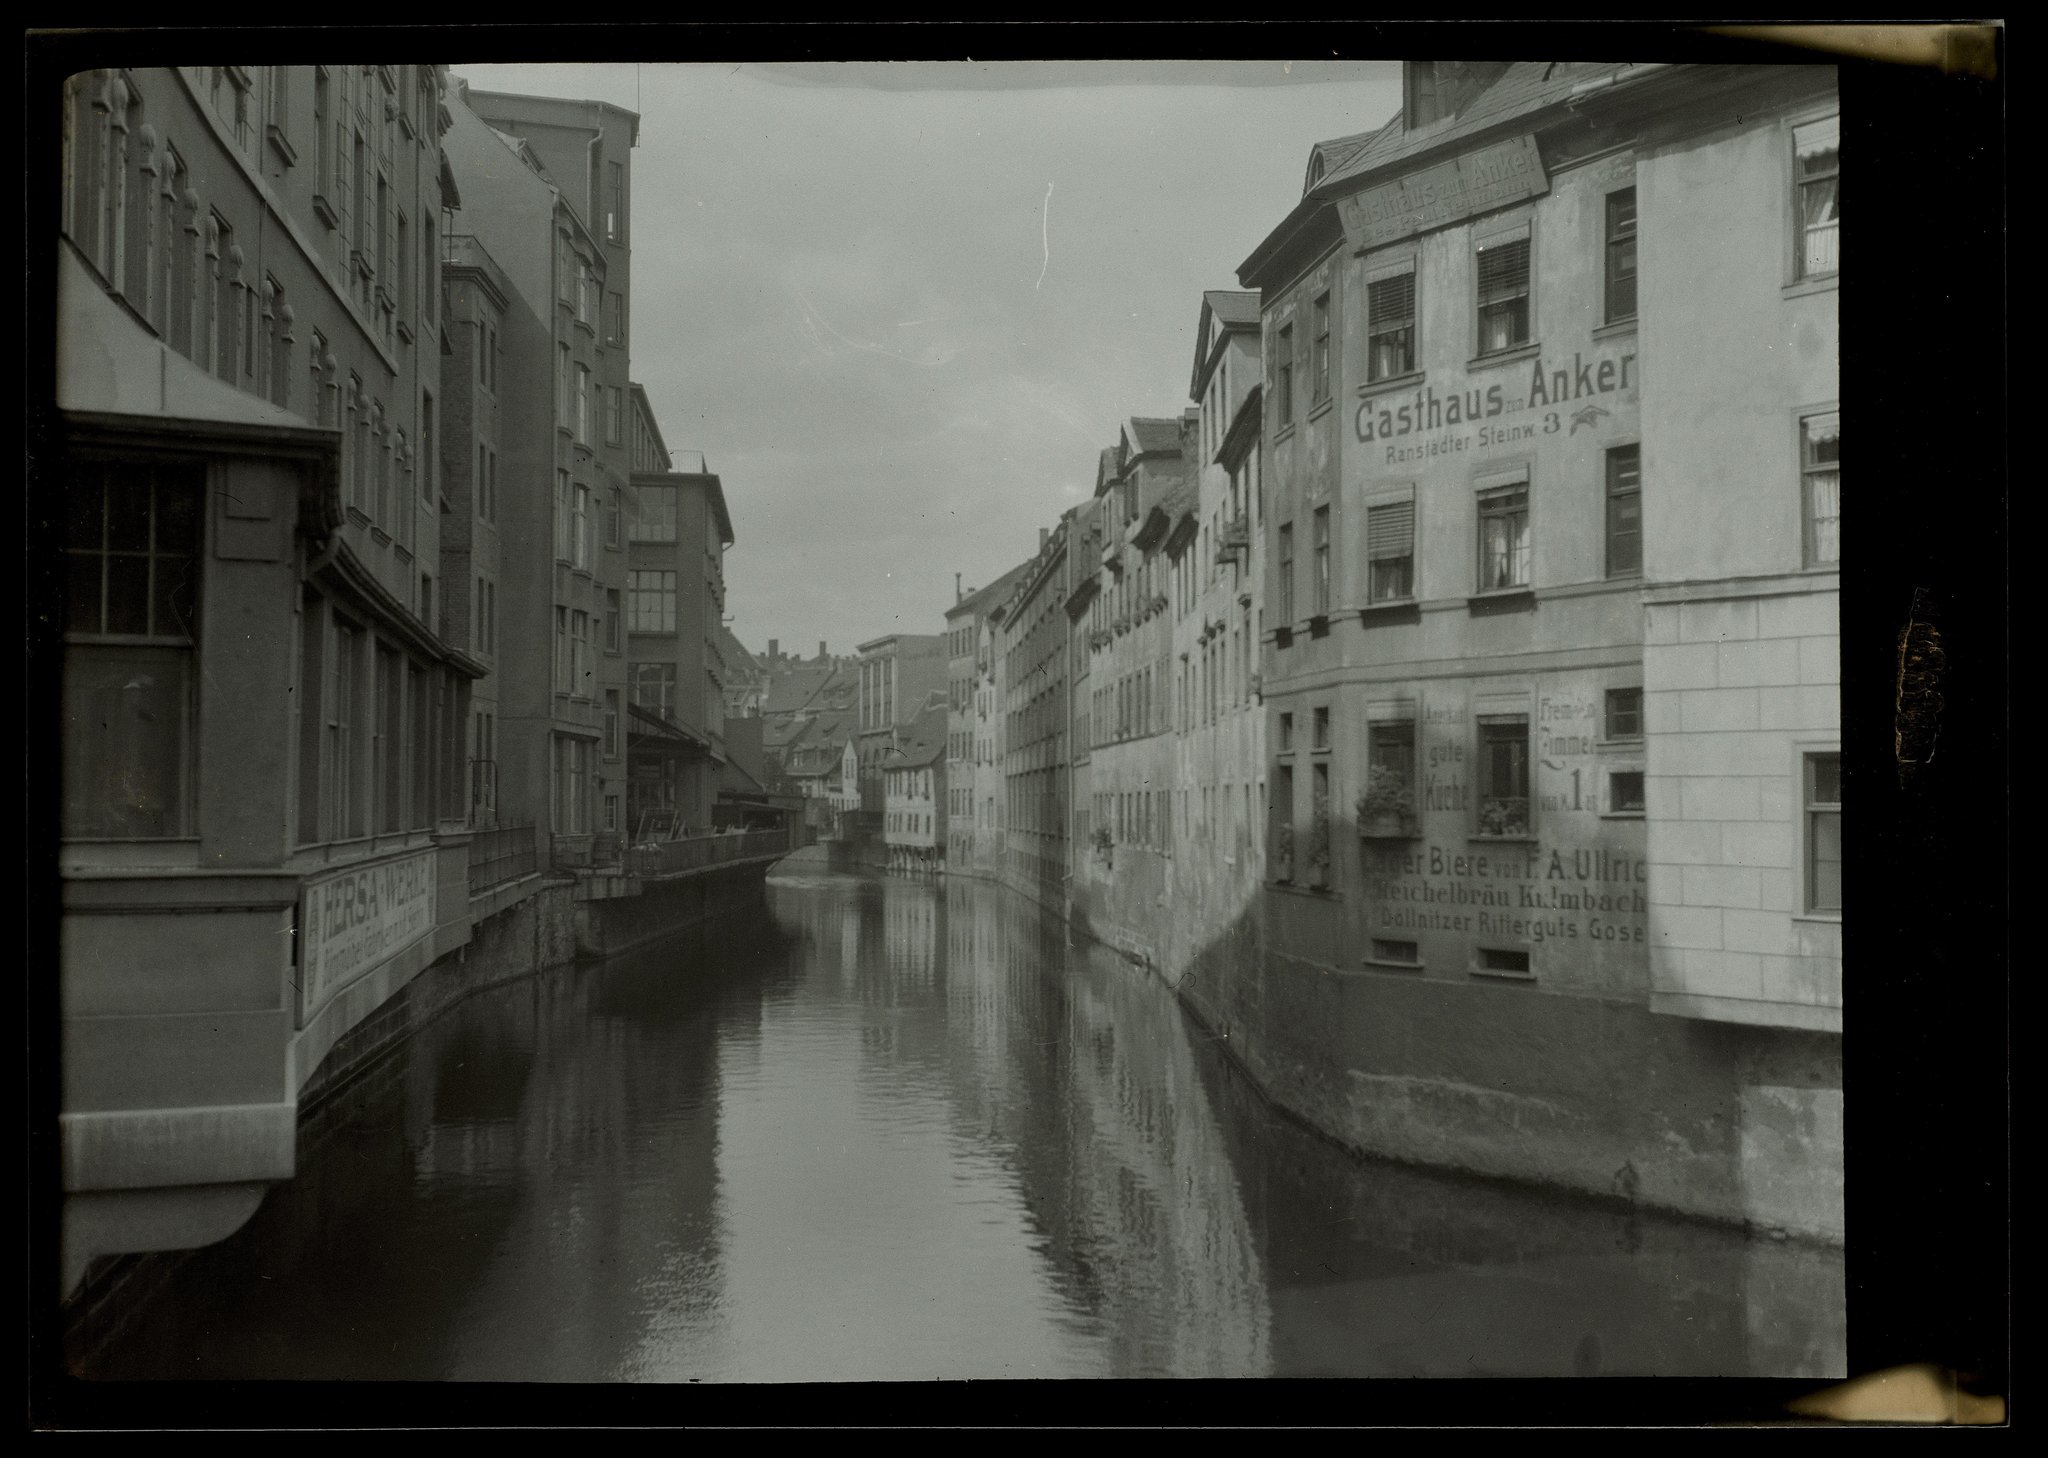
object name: photograph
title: Filmnegatief met opname van Leipzig en huis te Bünde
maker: Anonymous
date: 1921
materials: film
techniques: gelatin silver negative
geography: germany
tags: germany